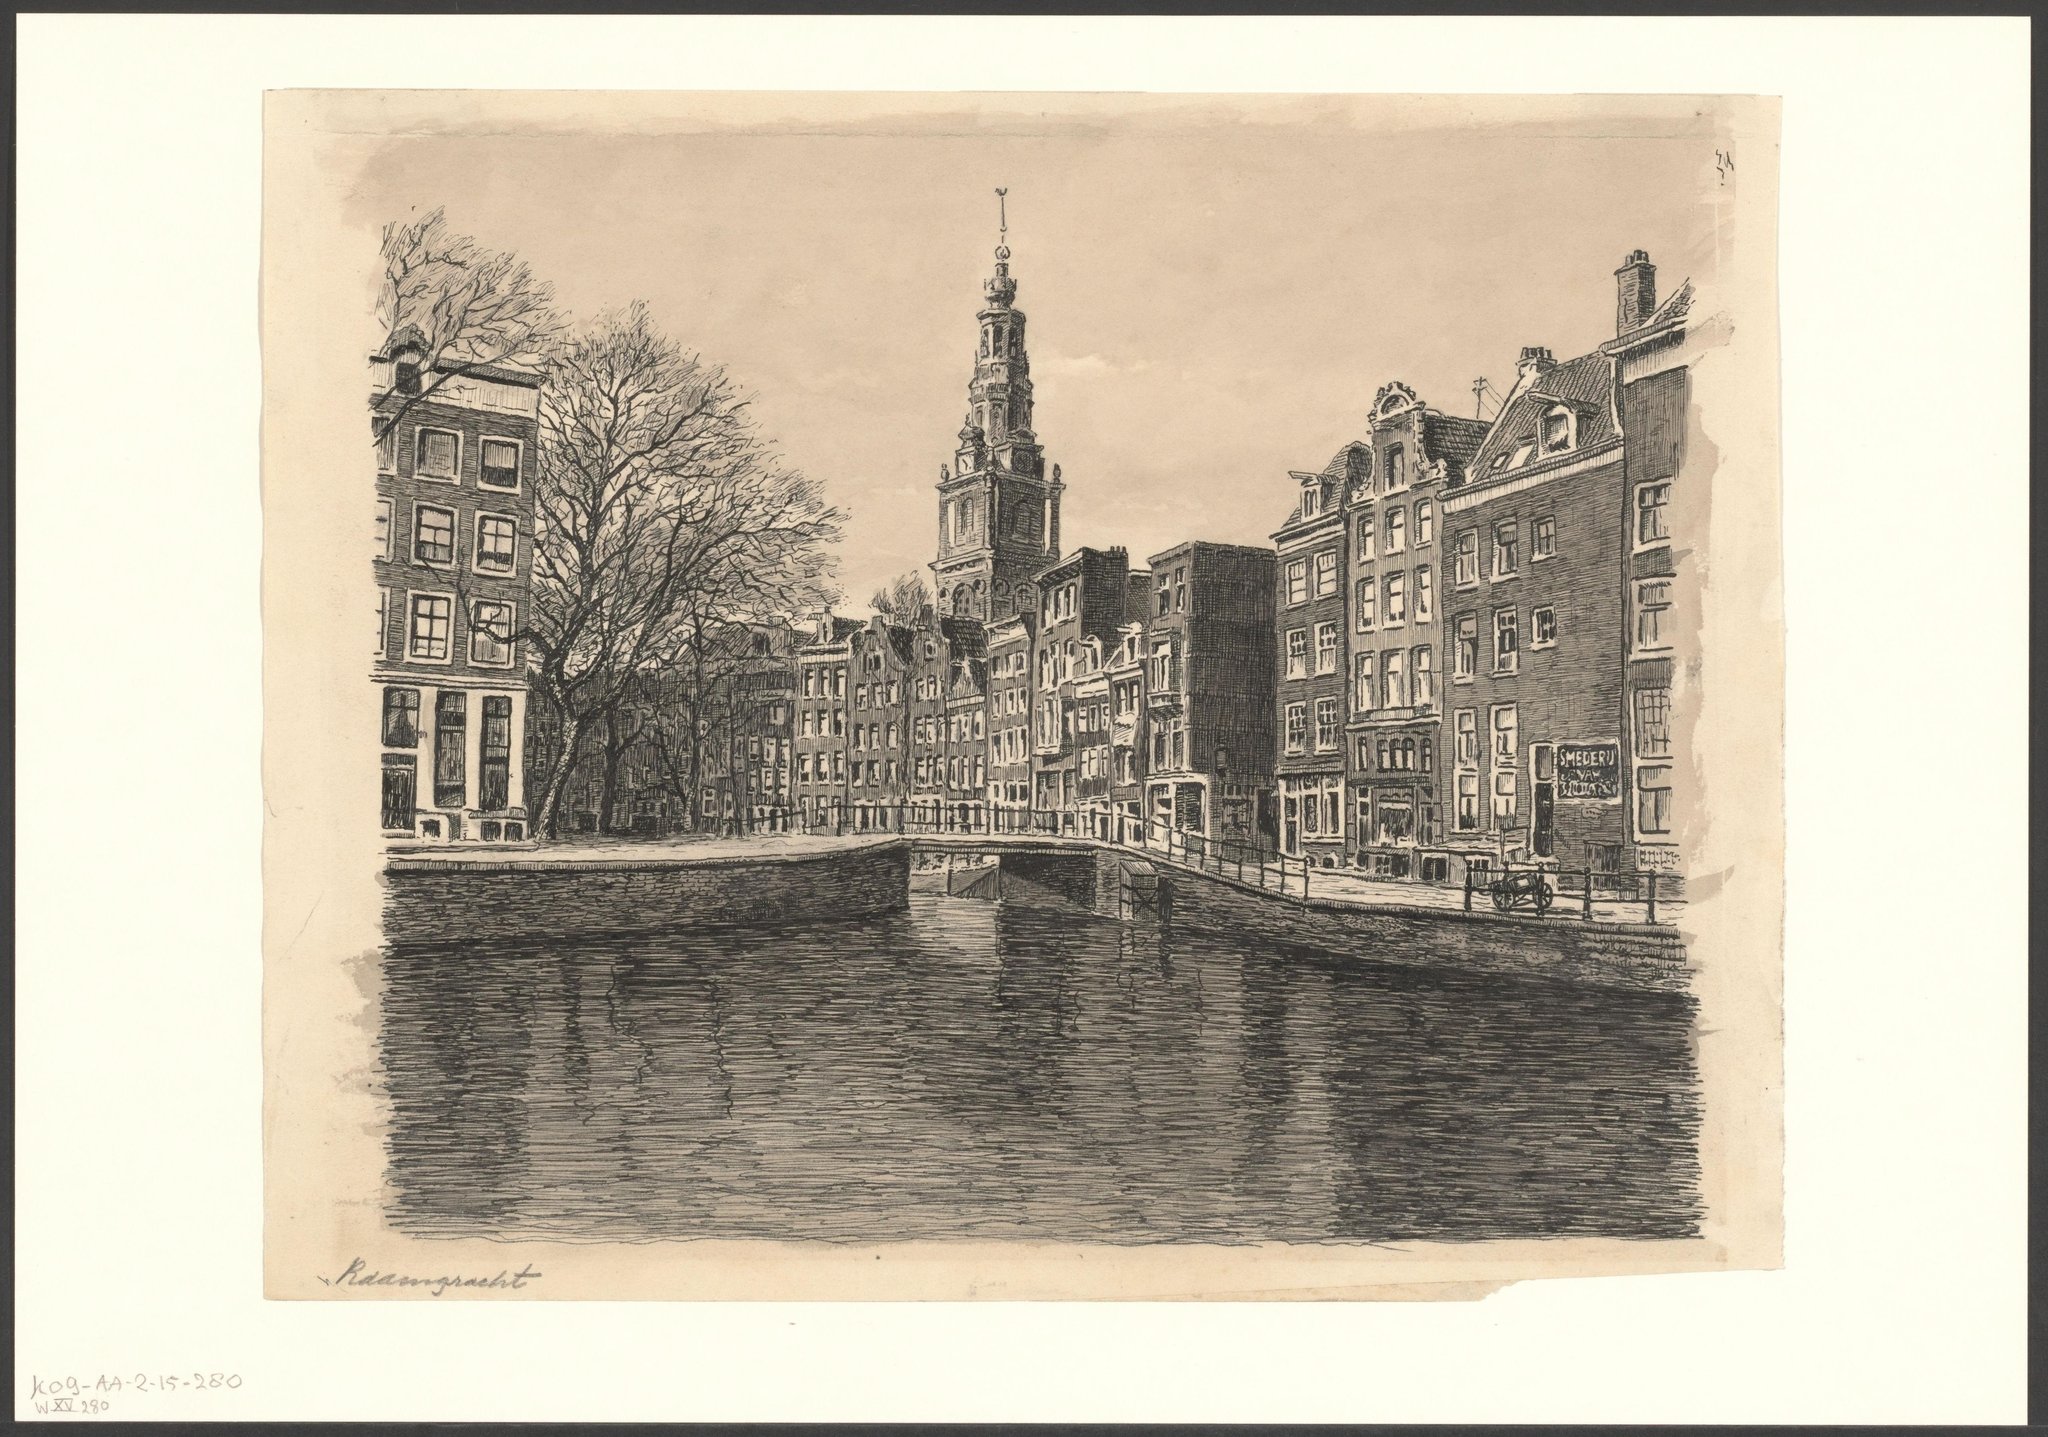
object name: drawing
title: Gezicht op de Raamgracht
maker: Anonymous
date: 1875-1975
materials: ink, paper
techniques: brush, pen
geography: amsterdam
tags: city-view in general; 'veduta', canal, bridge in city across river, canal, etc.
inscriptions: inscription: ‘Raamgracht’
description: Tekening binnen de Atlas Van Eck ingedeeld op wijknummer 15.